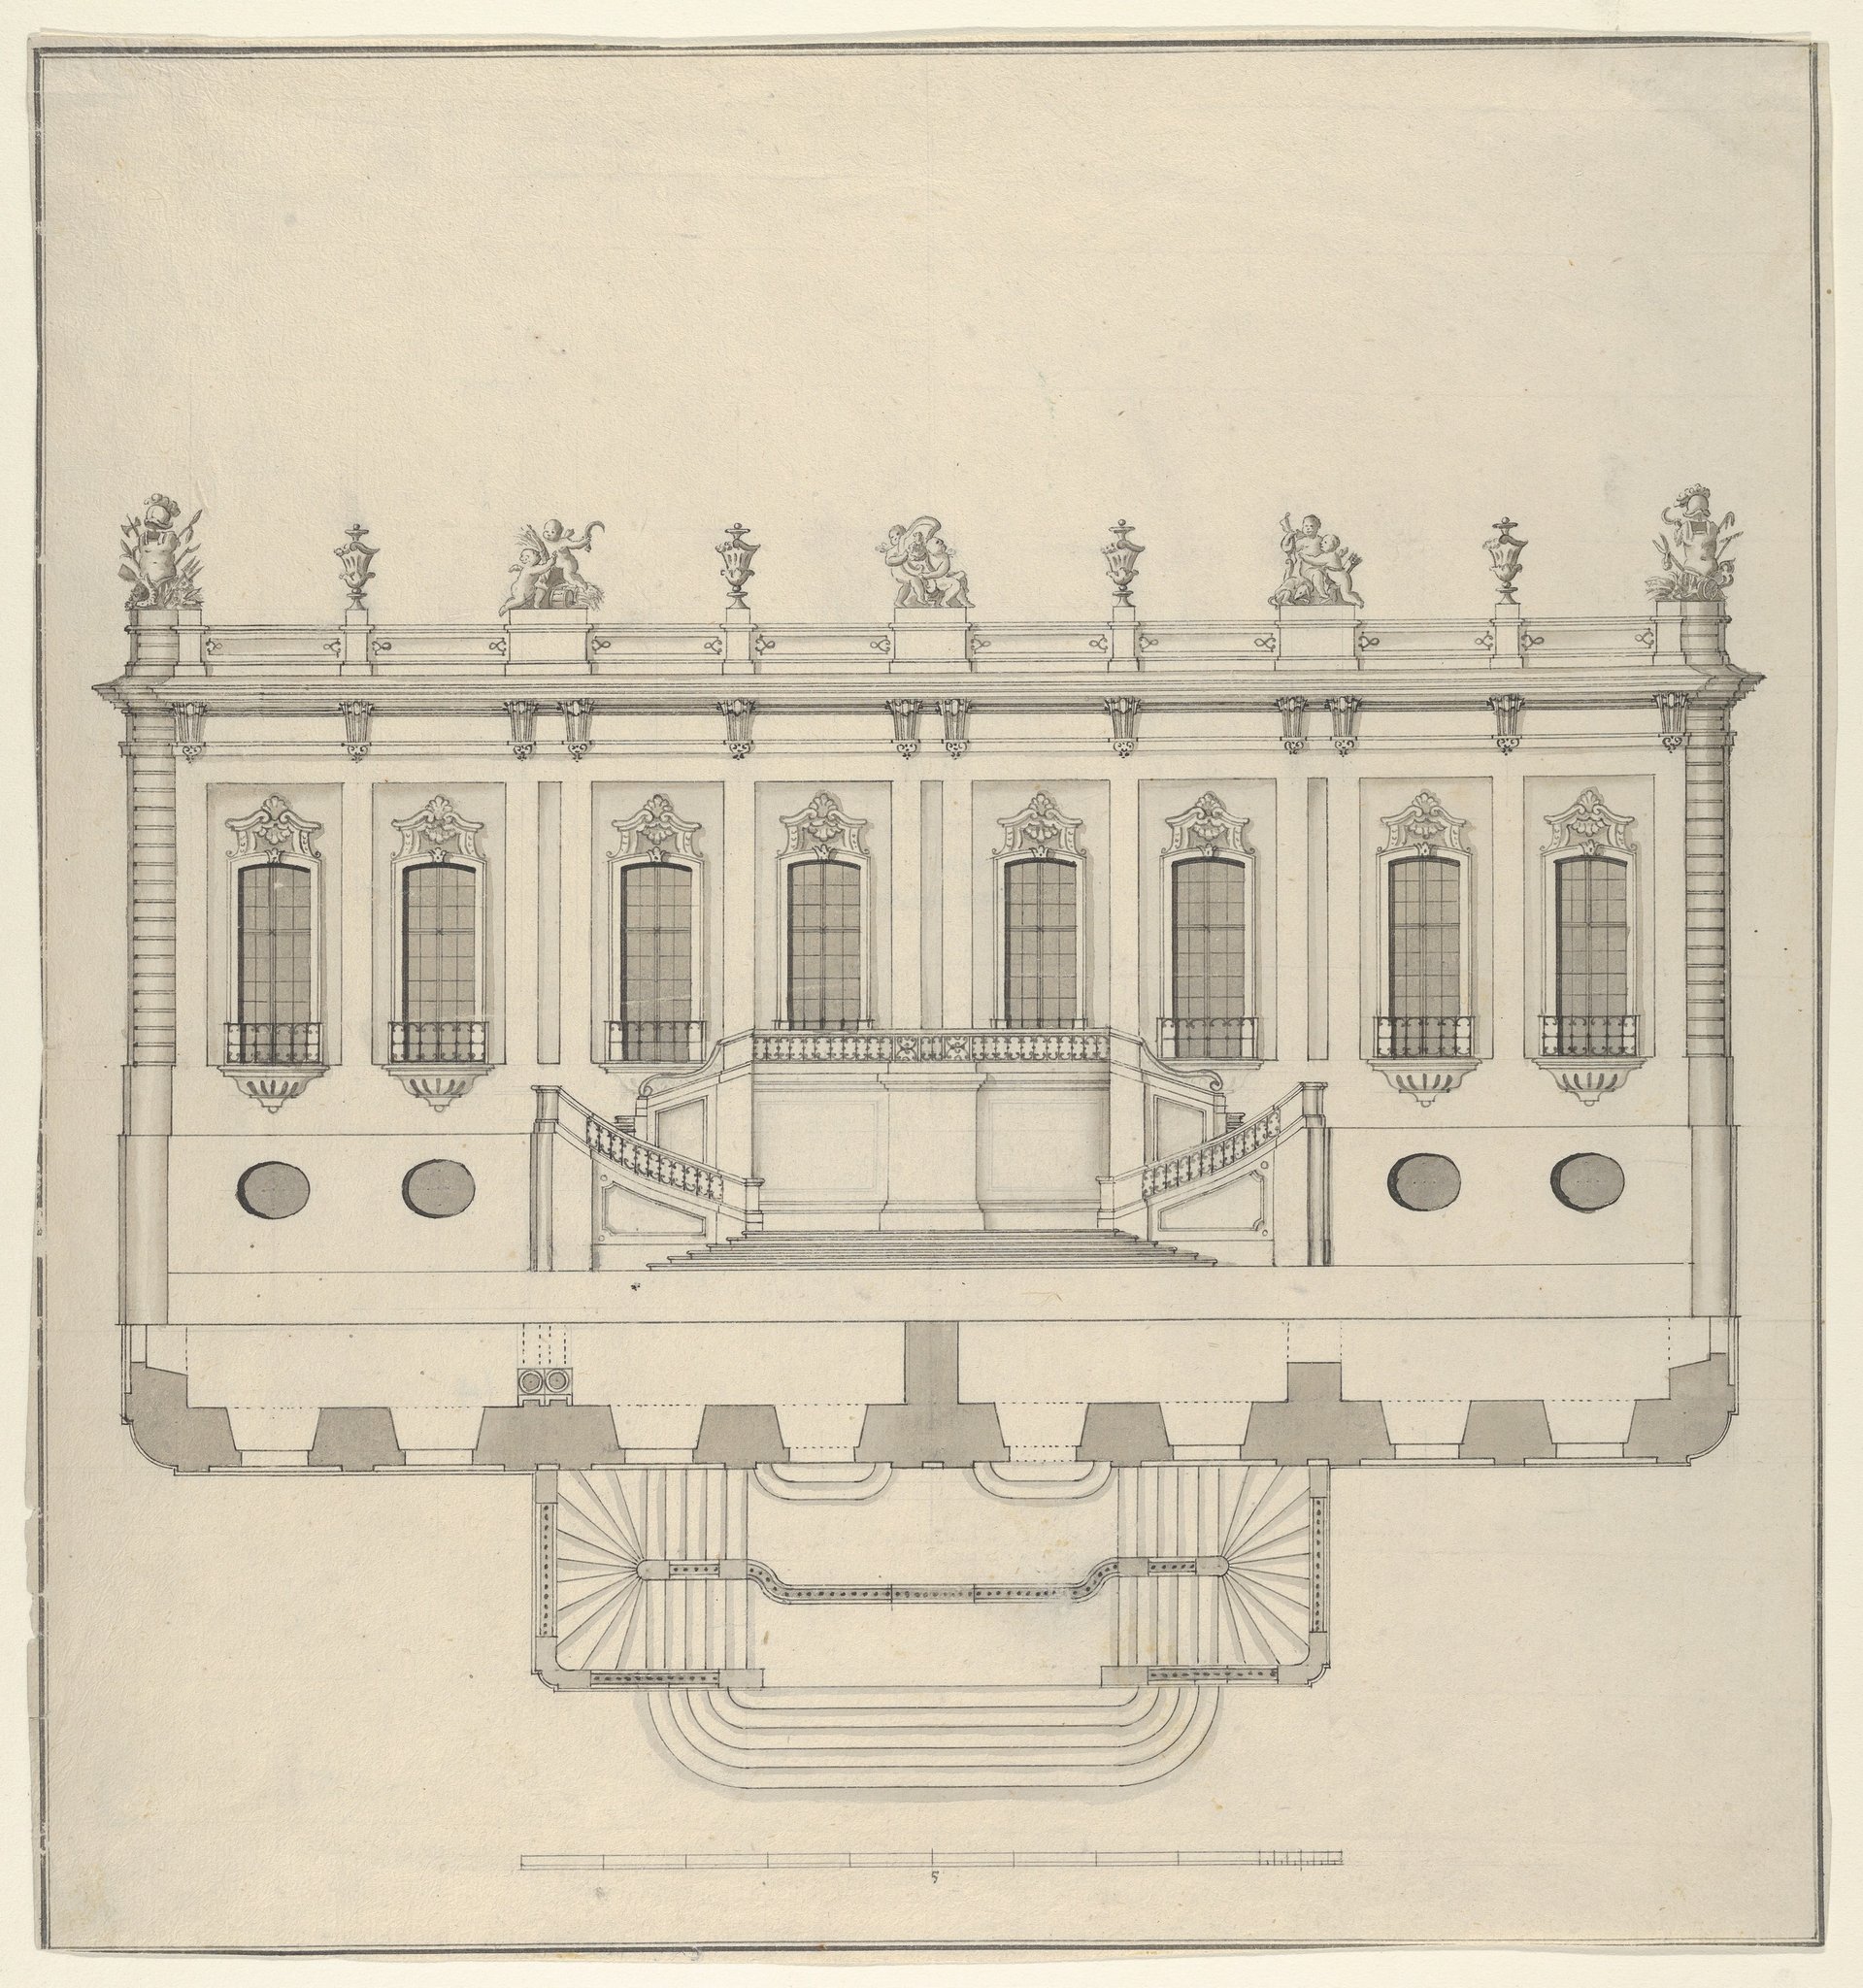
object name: drawing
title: Design for a Palace Façade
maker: Anonymous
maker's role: artist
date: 1700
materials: chalk, ink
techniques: brush, pen, wash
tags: architecture,palaces